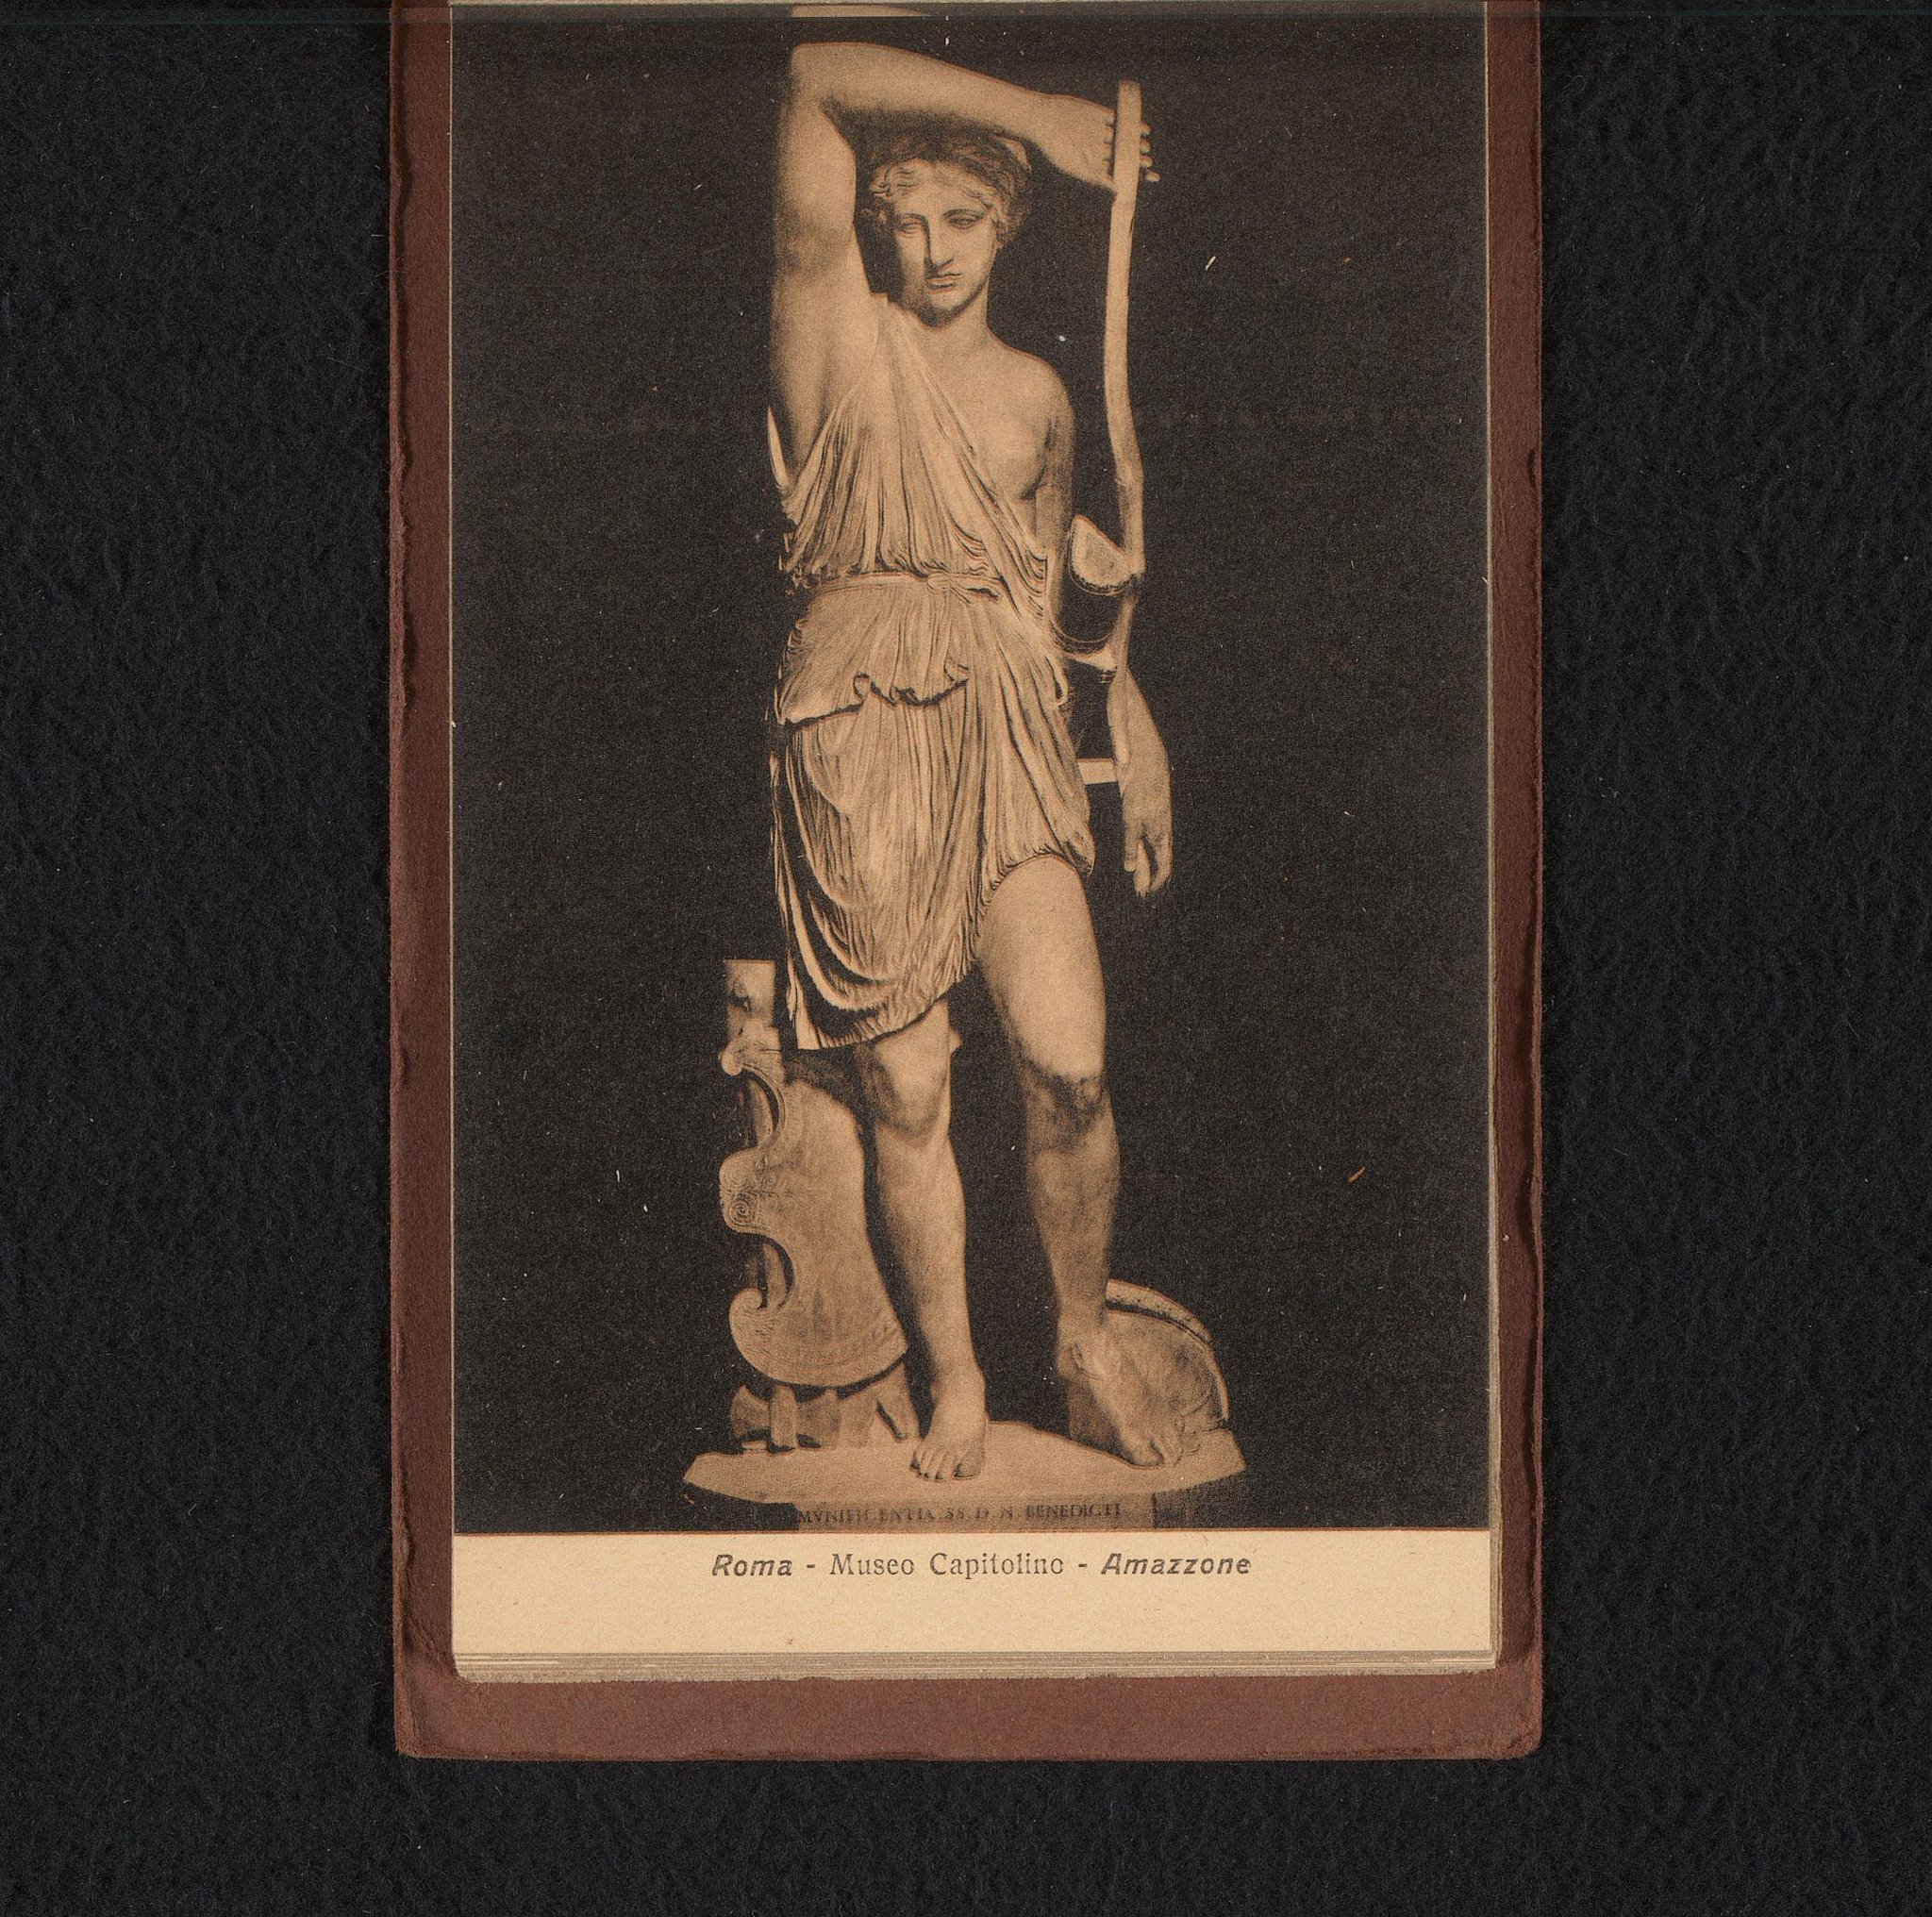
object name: ansichtkaart, prentbriefkaart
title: Roma - Museo Capitolino - Amazzone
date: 1905-1930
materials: cardboard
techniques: photograph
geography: rome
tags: statues, paintings, etc. ~ objects of worship in roman religion, permanent exhibition, museum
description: Prentbriefkaart maakt deel uit van een album.